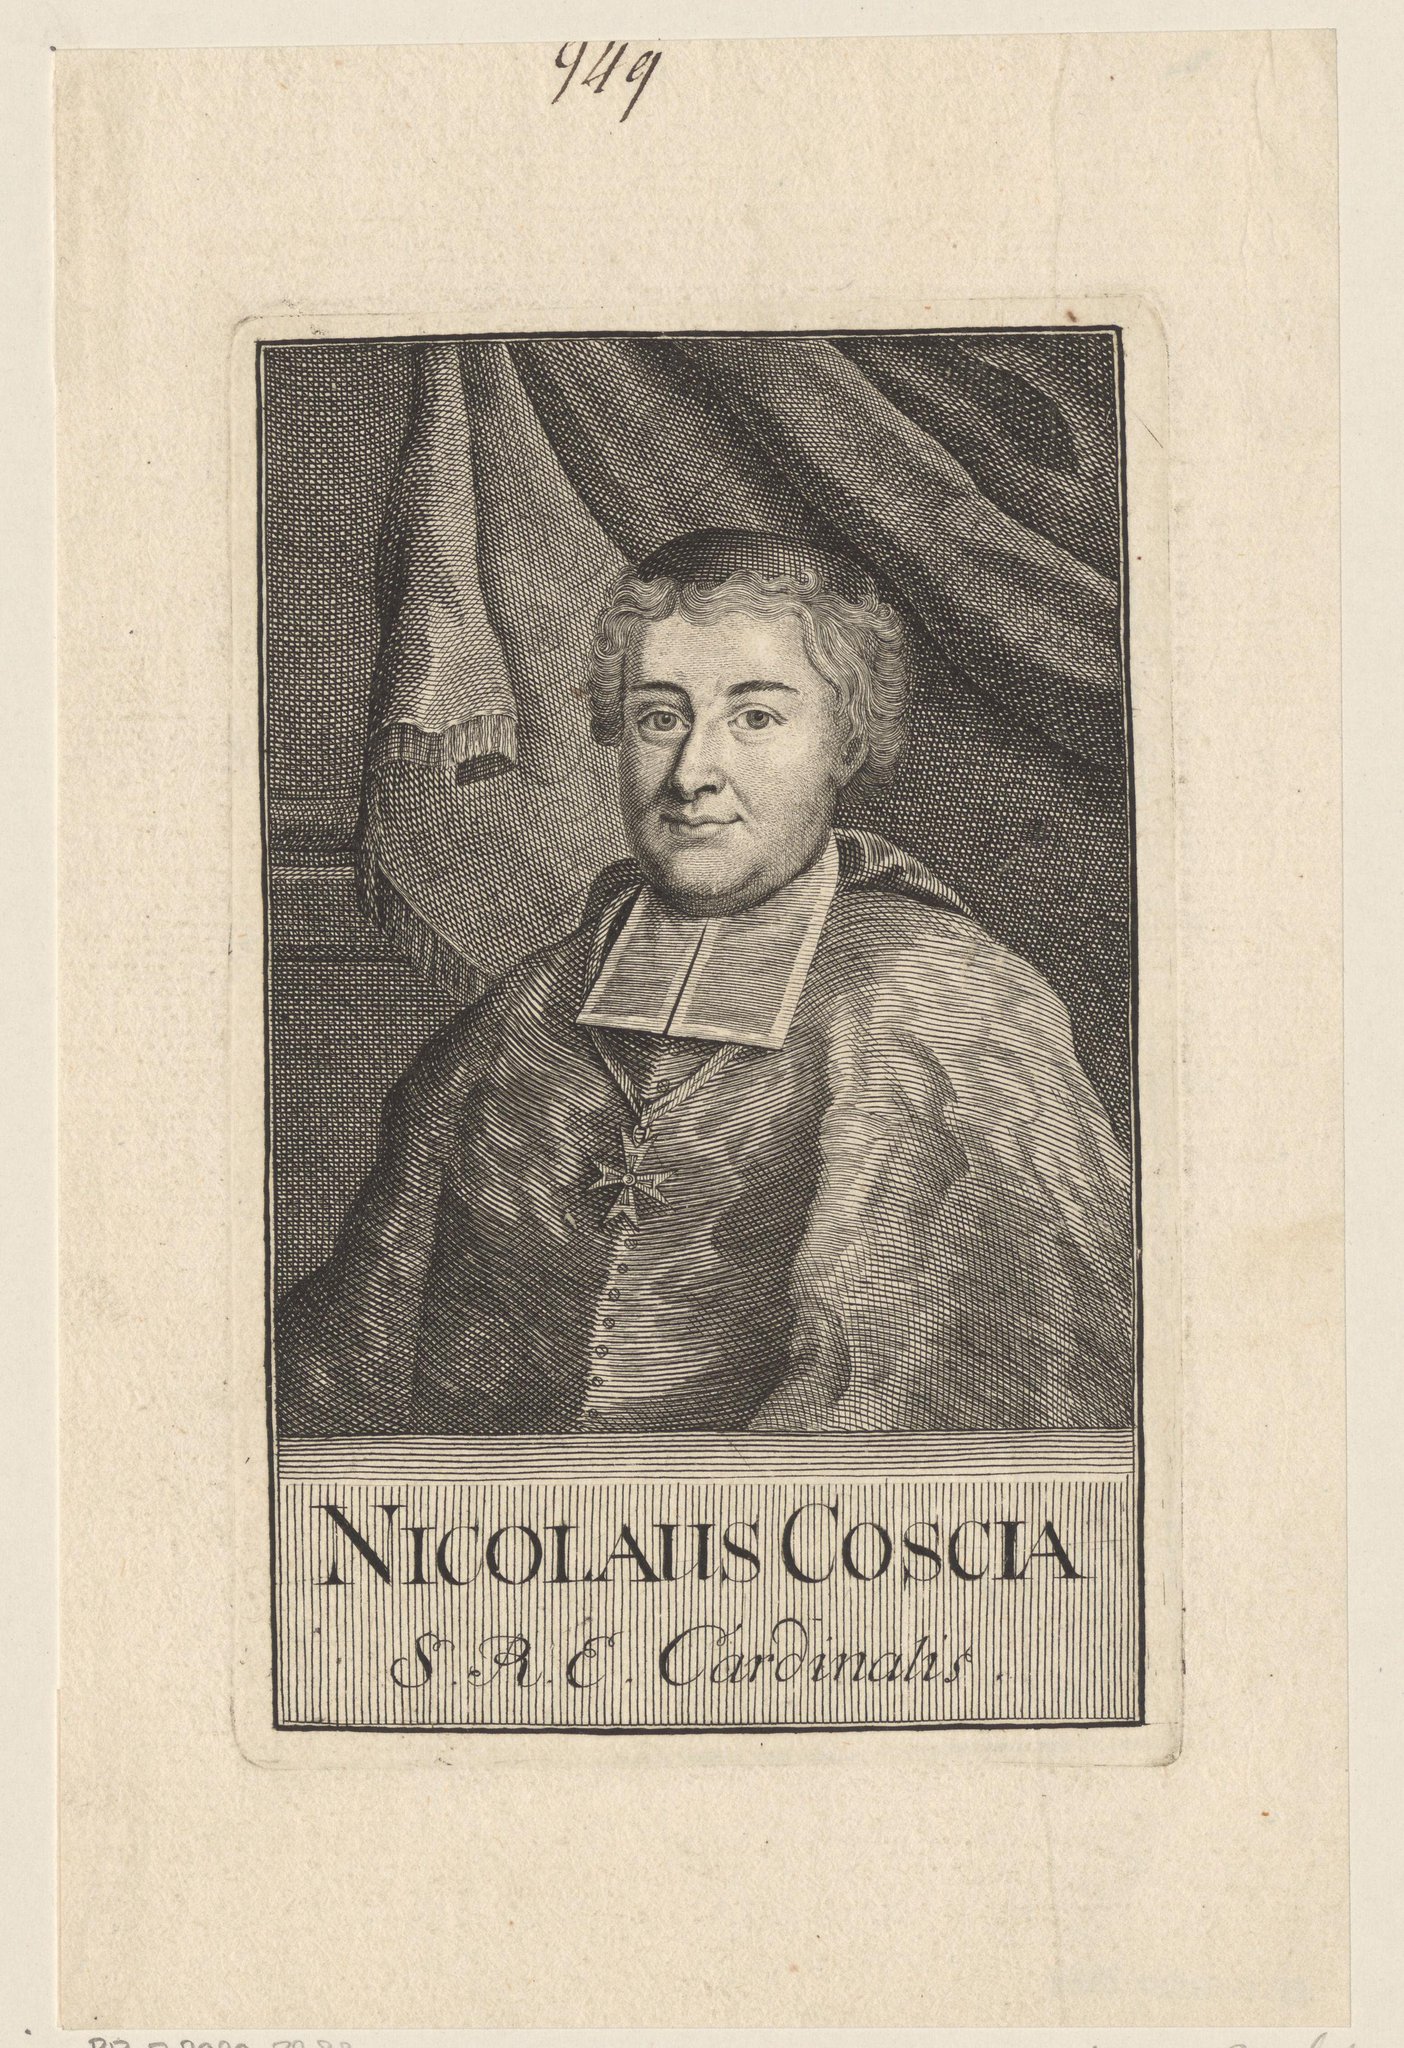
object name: print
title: Portret van Niccolò Coscia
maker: Anonymous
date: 1725-1799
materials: paper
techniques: engraving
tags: italy, historical persons